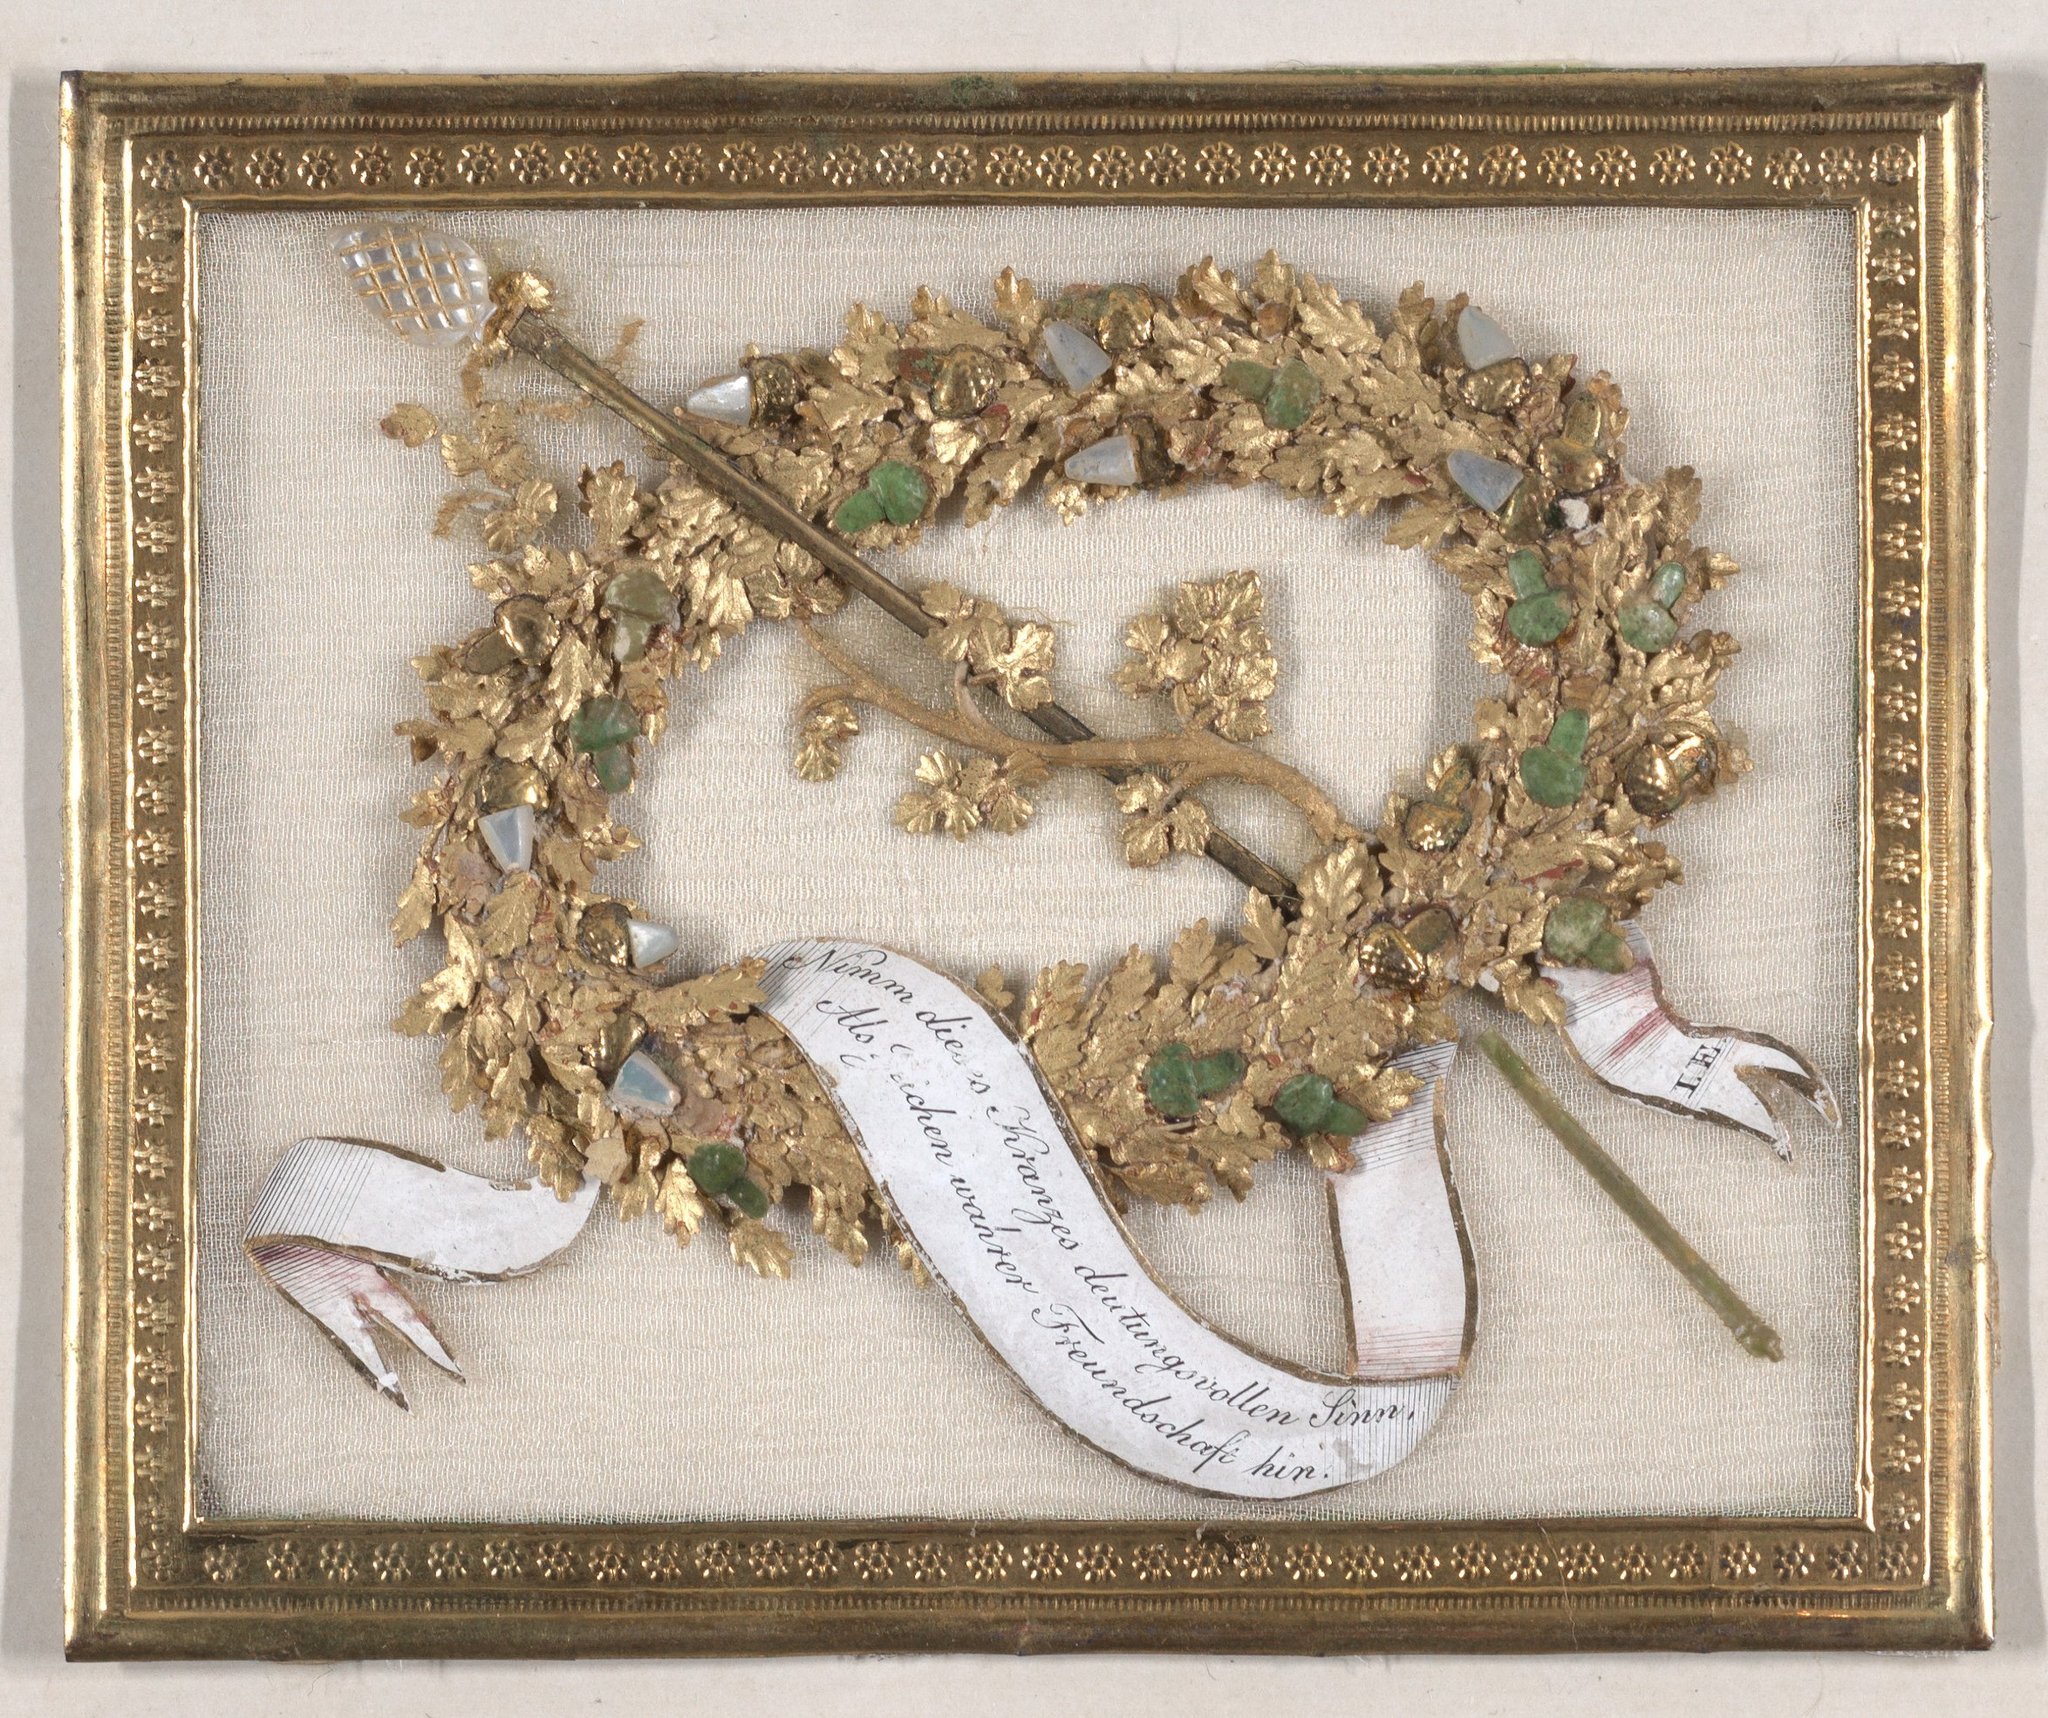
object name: greeting card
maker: johannes endletzberger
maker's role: artist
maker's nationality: austrian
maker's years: 1782-1850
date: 1810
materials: foil, gouache, mother of pearl, paint, paper, silk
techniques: carving, embossing, painting